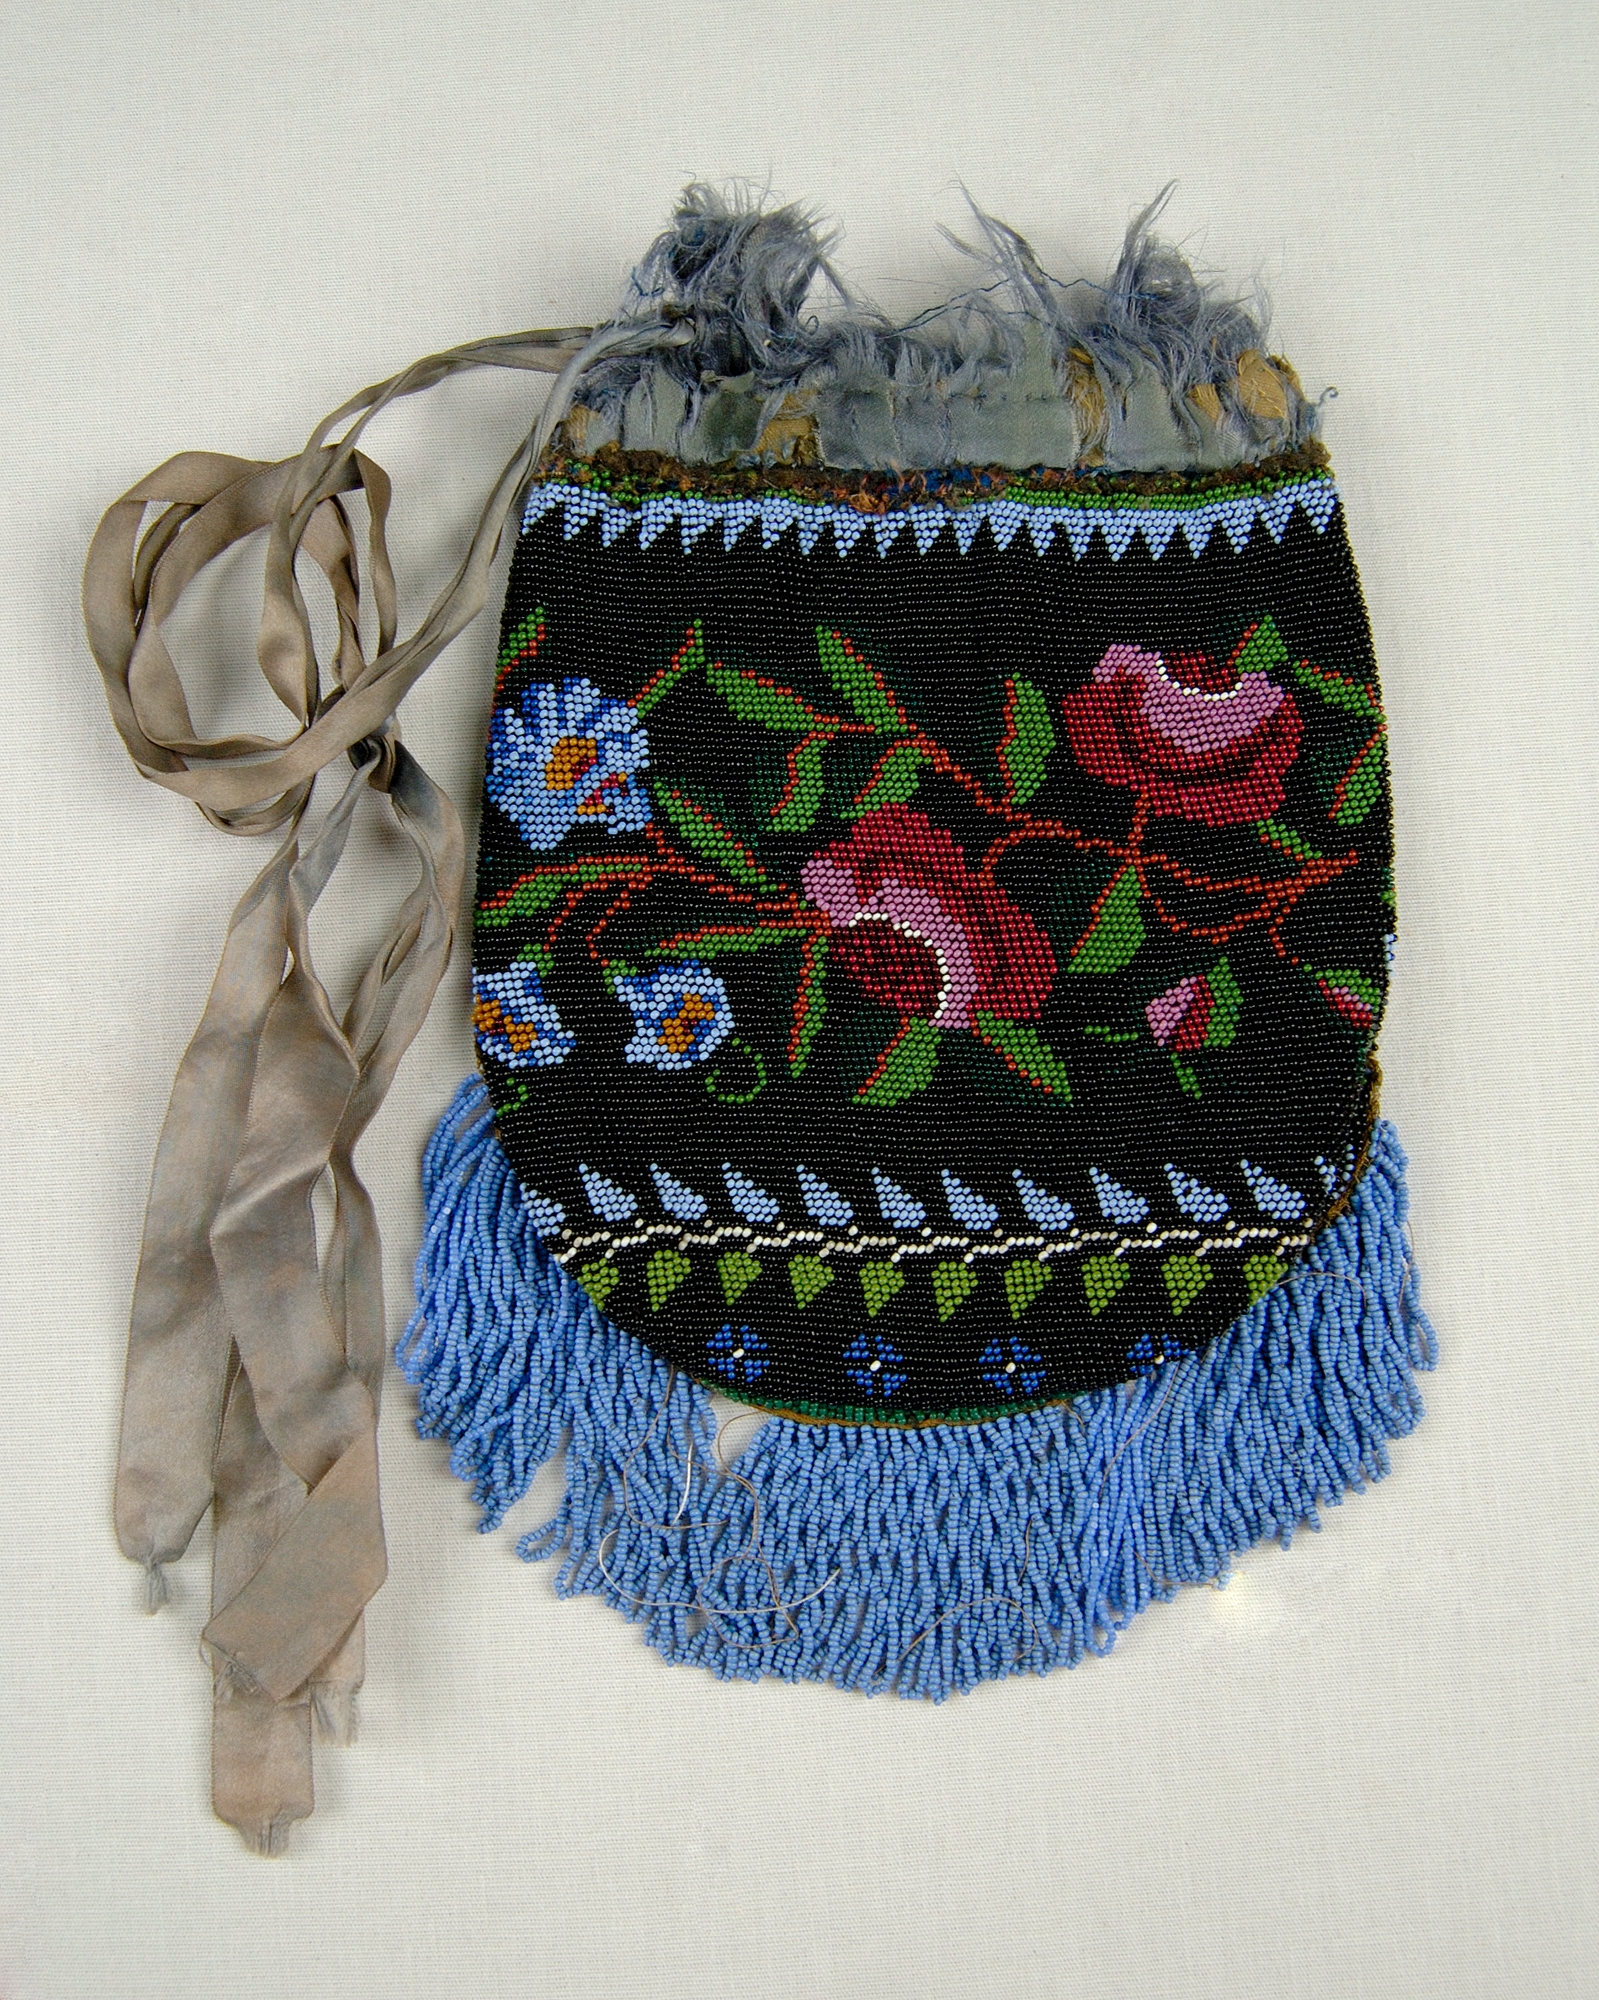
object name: pouch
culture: american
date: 1840-1860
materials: glass, linen, silk